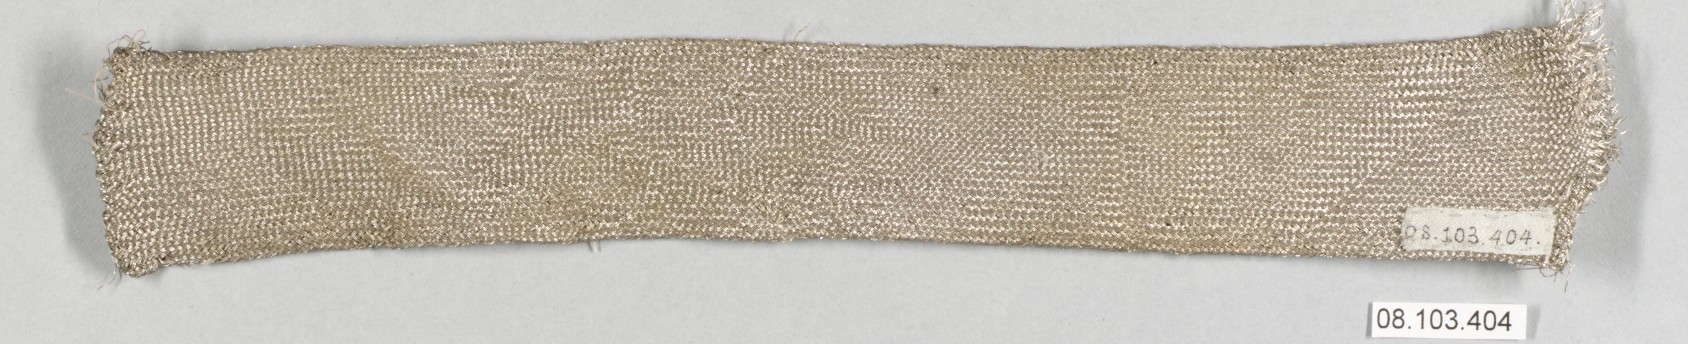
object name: galloon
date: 1701-1900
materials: metal thread